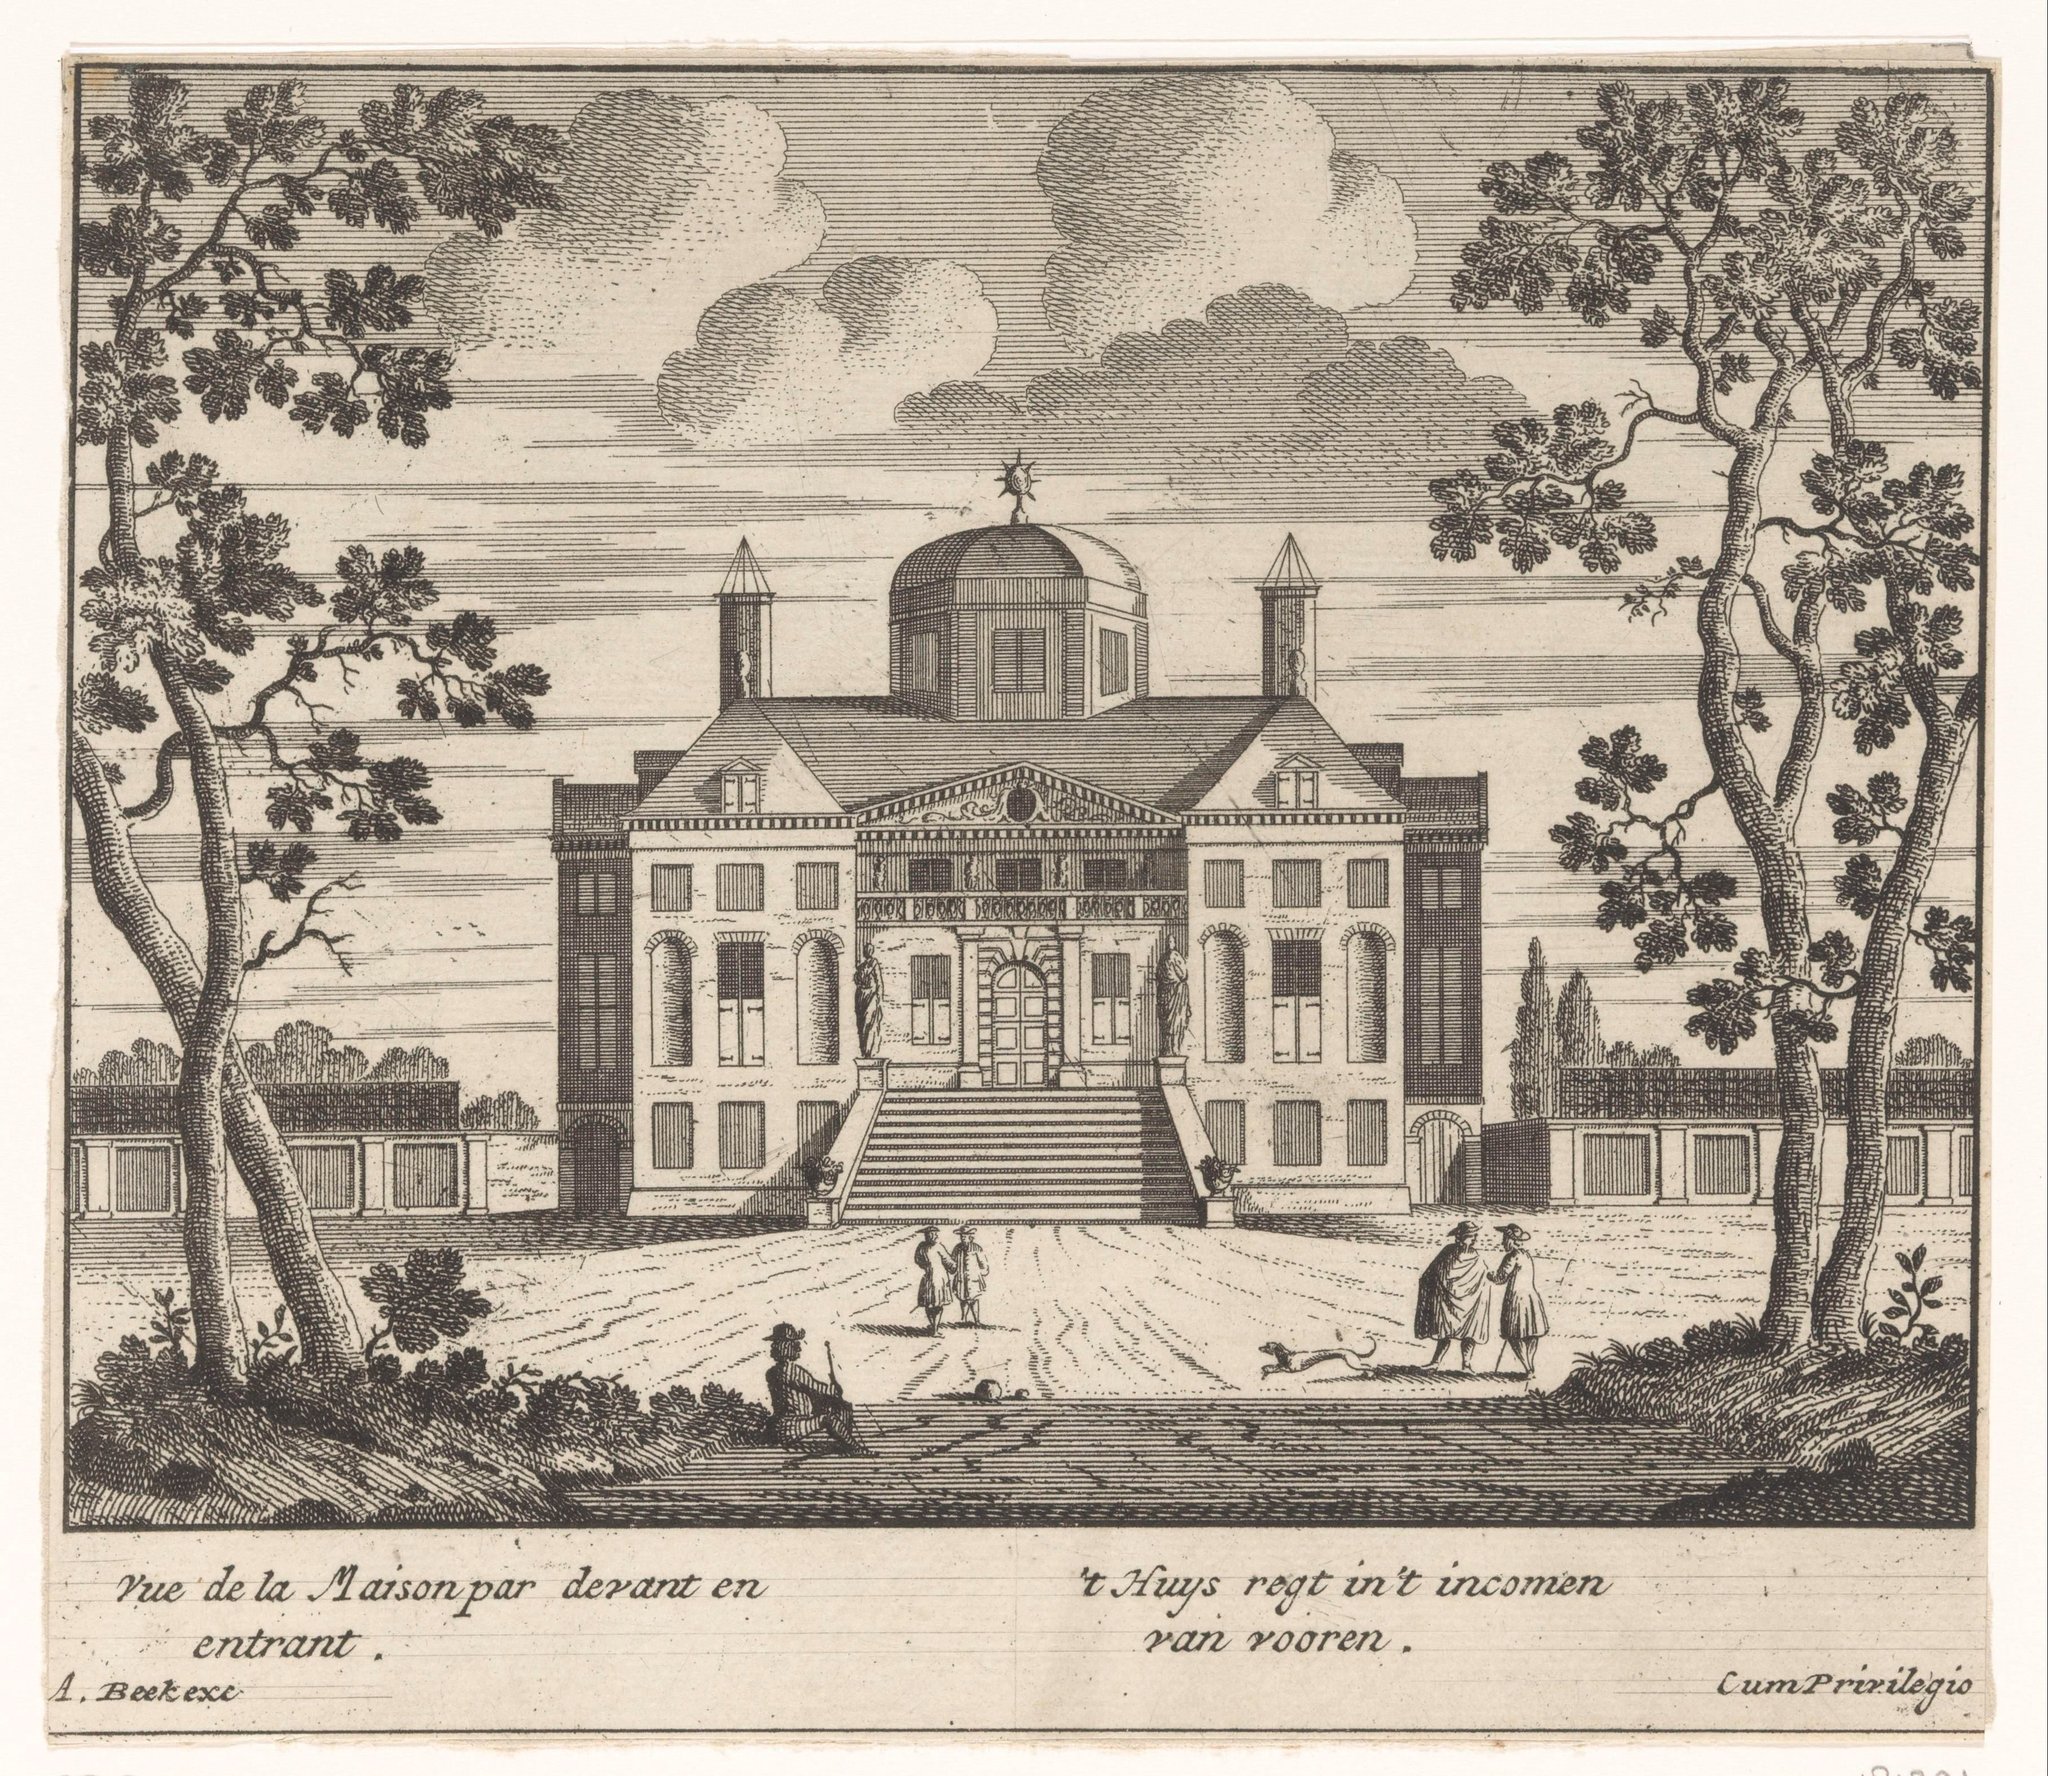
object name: print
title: Gezicht op de voorkant van Huis ten Bosch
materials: paper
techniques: engraving, etching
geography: the hague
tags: palace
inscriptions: collector's mark: Lugt 2228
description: Mogelijk uitgegeven als onderdeel van een serie van zestien prenten en een panorama van Huis ten Bosch. Zie ook RP-P-AO-12-97-1, RP-P-AO-12-97-2, RP-P-AO-12-97-3, RP-P-AO-12-97-4, RP-P-AO-12-97-5, RP-P-AO-12-97-6, RP-P-AO-12-97-7, RP-P-AO-12-97-8, RP-P-AO-12-97-10, RP-P-AO-12-97-11, RP-P-AO-12-97-12, RP-P-AO-12-97-13, RP-P-AO-12-97-14 en RP-P-AO-12-97-15.